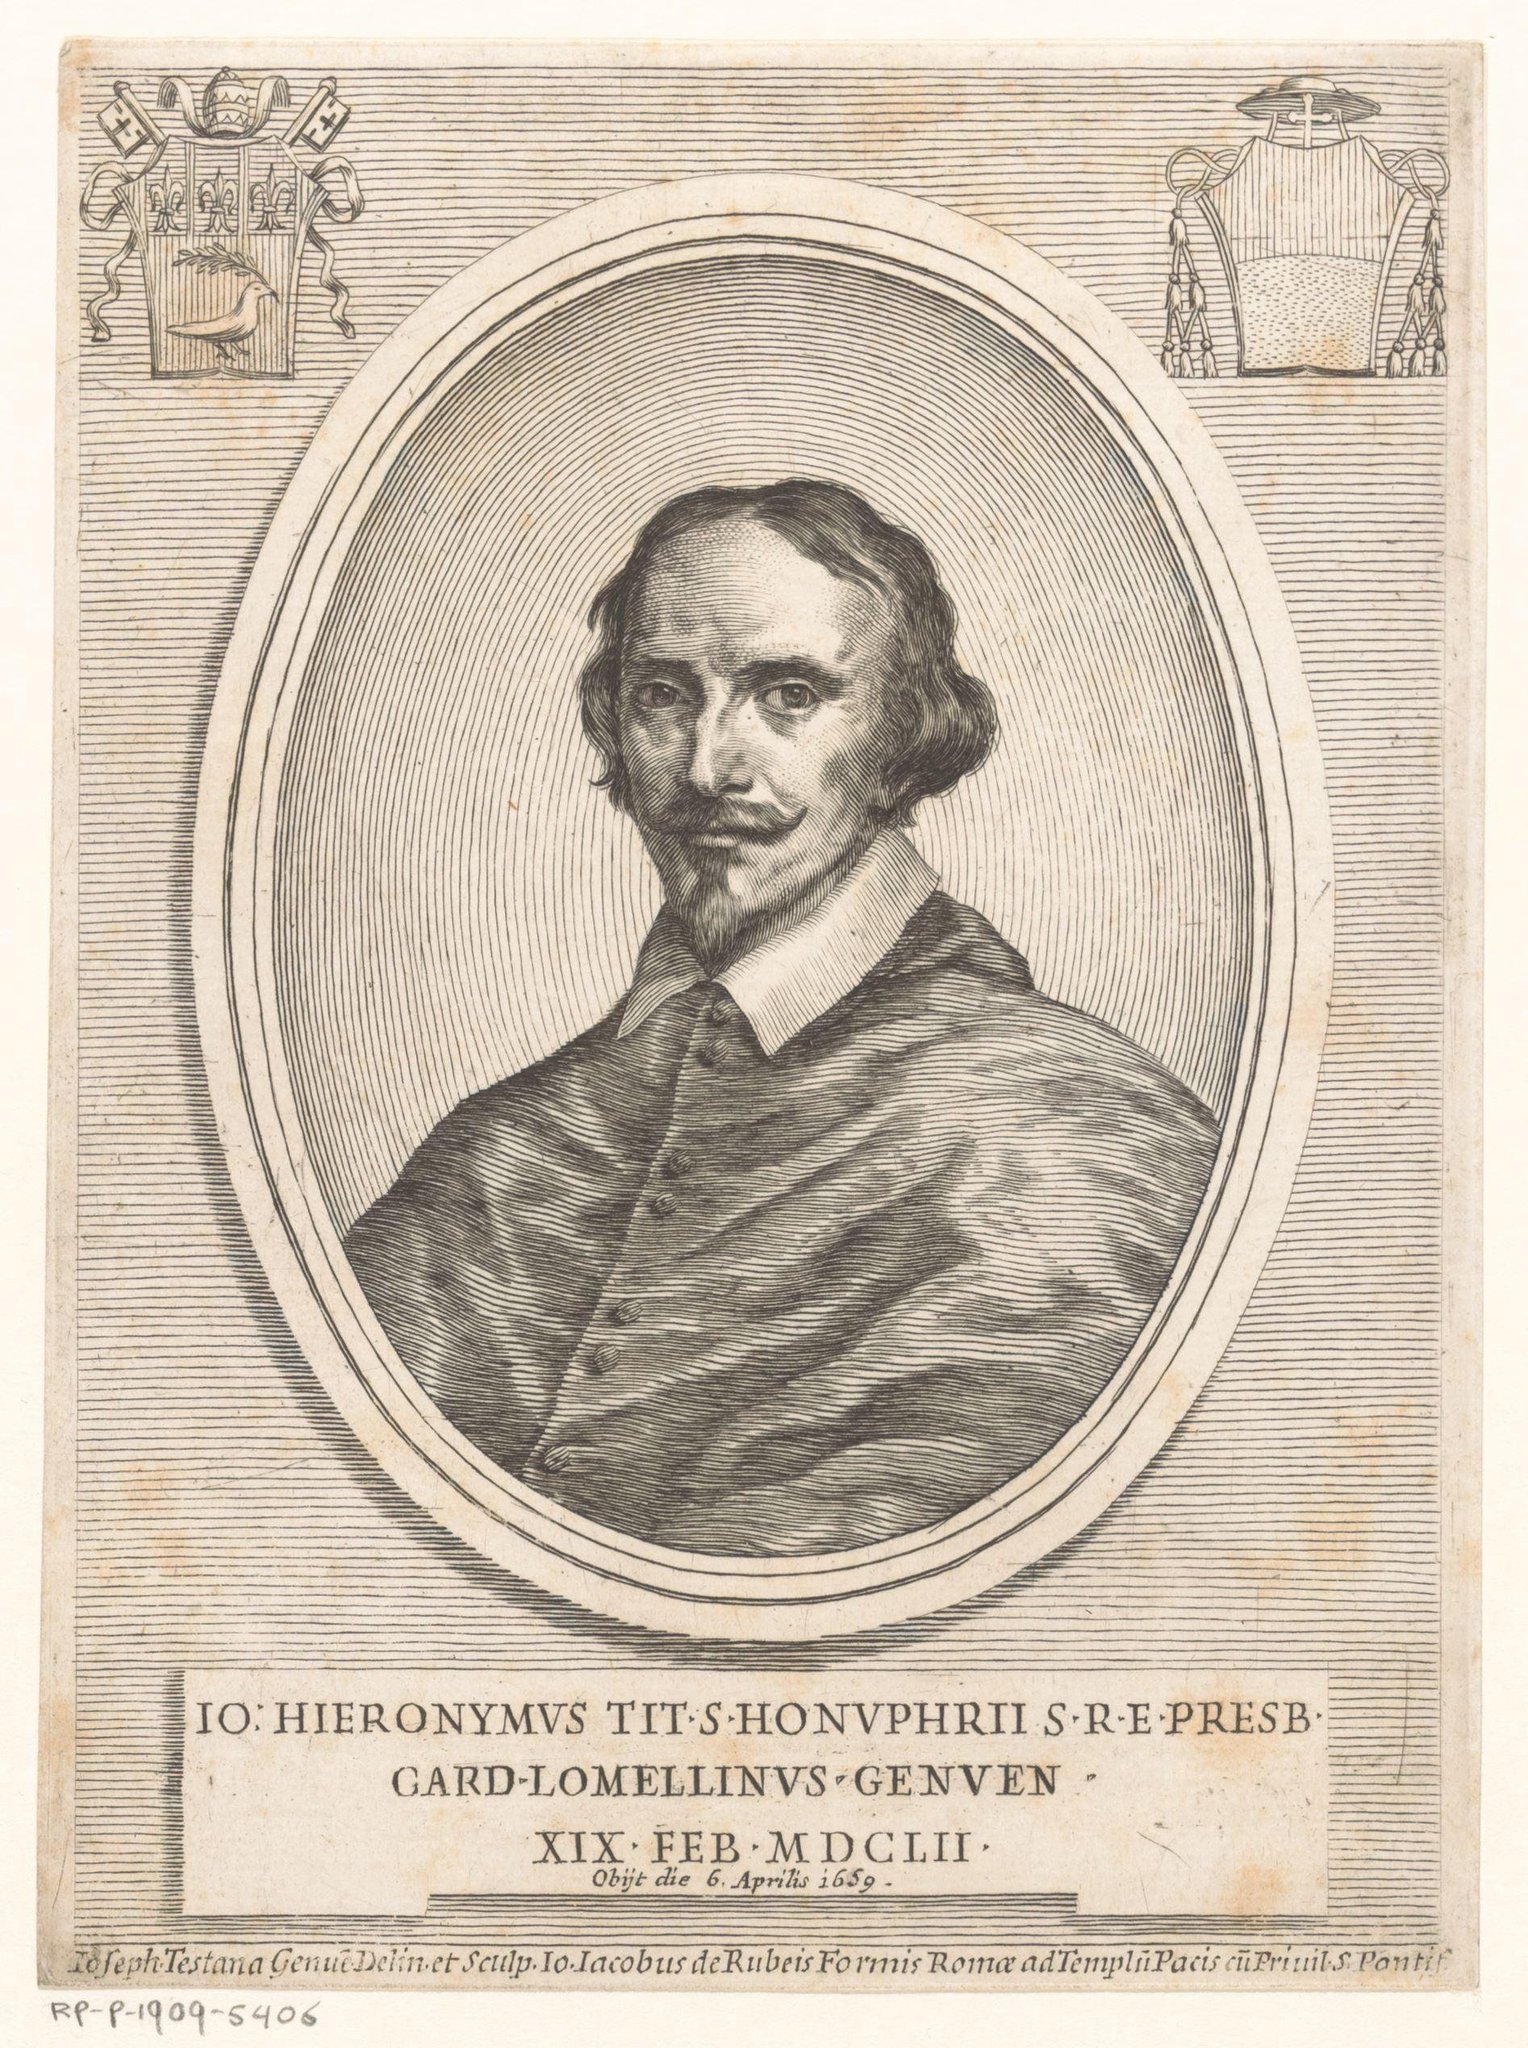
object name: print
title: Portret van kardinaal Giovanni Girolamo Lomellini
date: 1658-1679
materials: paper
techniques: engraving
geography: rome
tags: rome, cardinal, historical persons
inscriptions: collector's mark: Lugt 2228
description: Prent uit een reeks van onbekende omvang met portretten van kardinalen. De prenten werden vanaf 1657 vervaardigd in opdracht van uitgever Giovanni Giacomo de’ Rossi, waarna de productie werd voortgezet onder leiding van zijn opvolgers Domenico de’ Rossi en Lorenzo Filippo de’ Rossi, en ten slotte onder leiding van de Calcographia R.C.A.